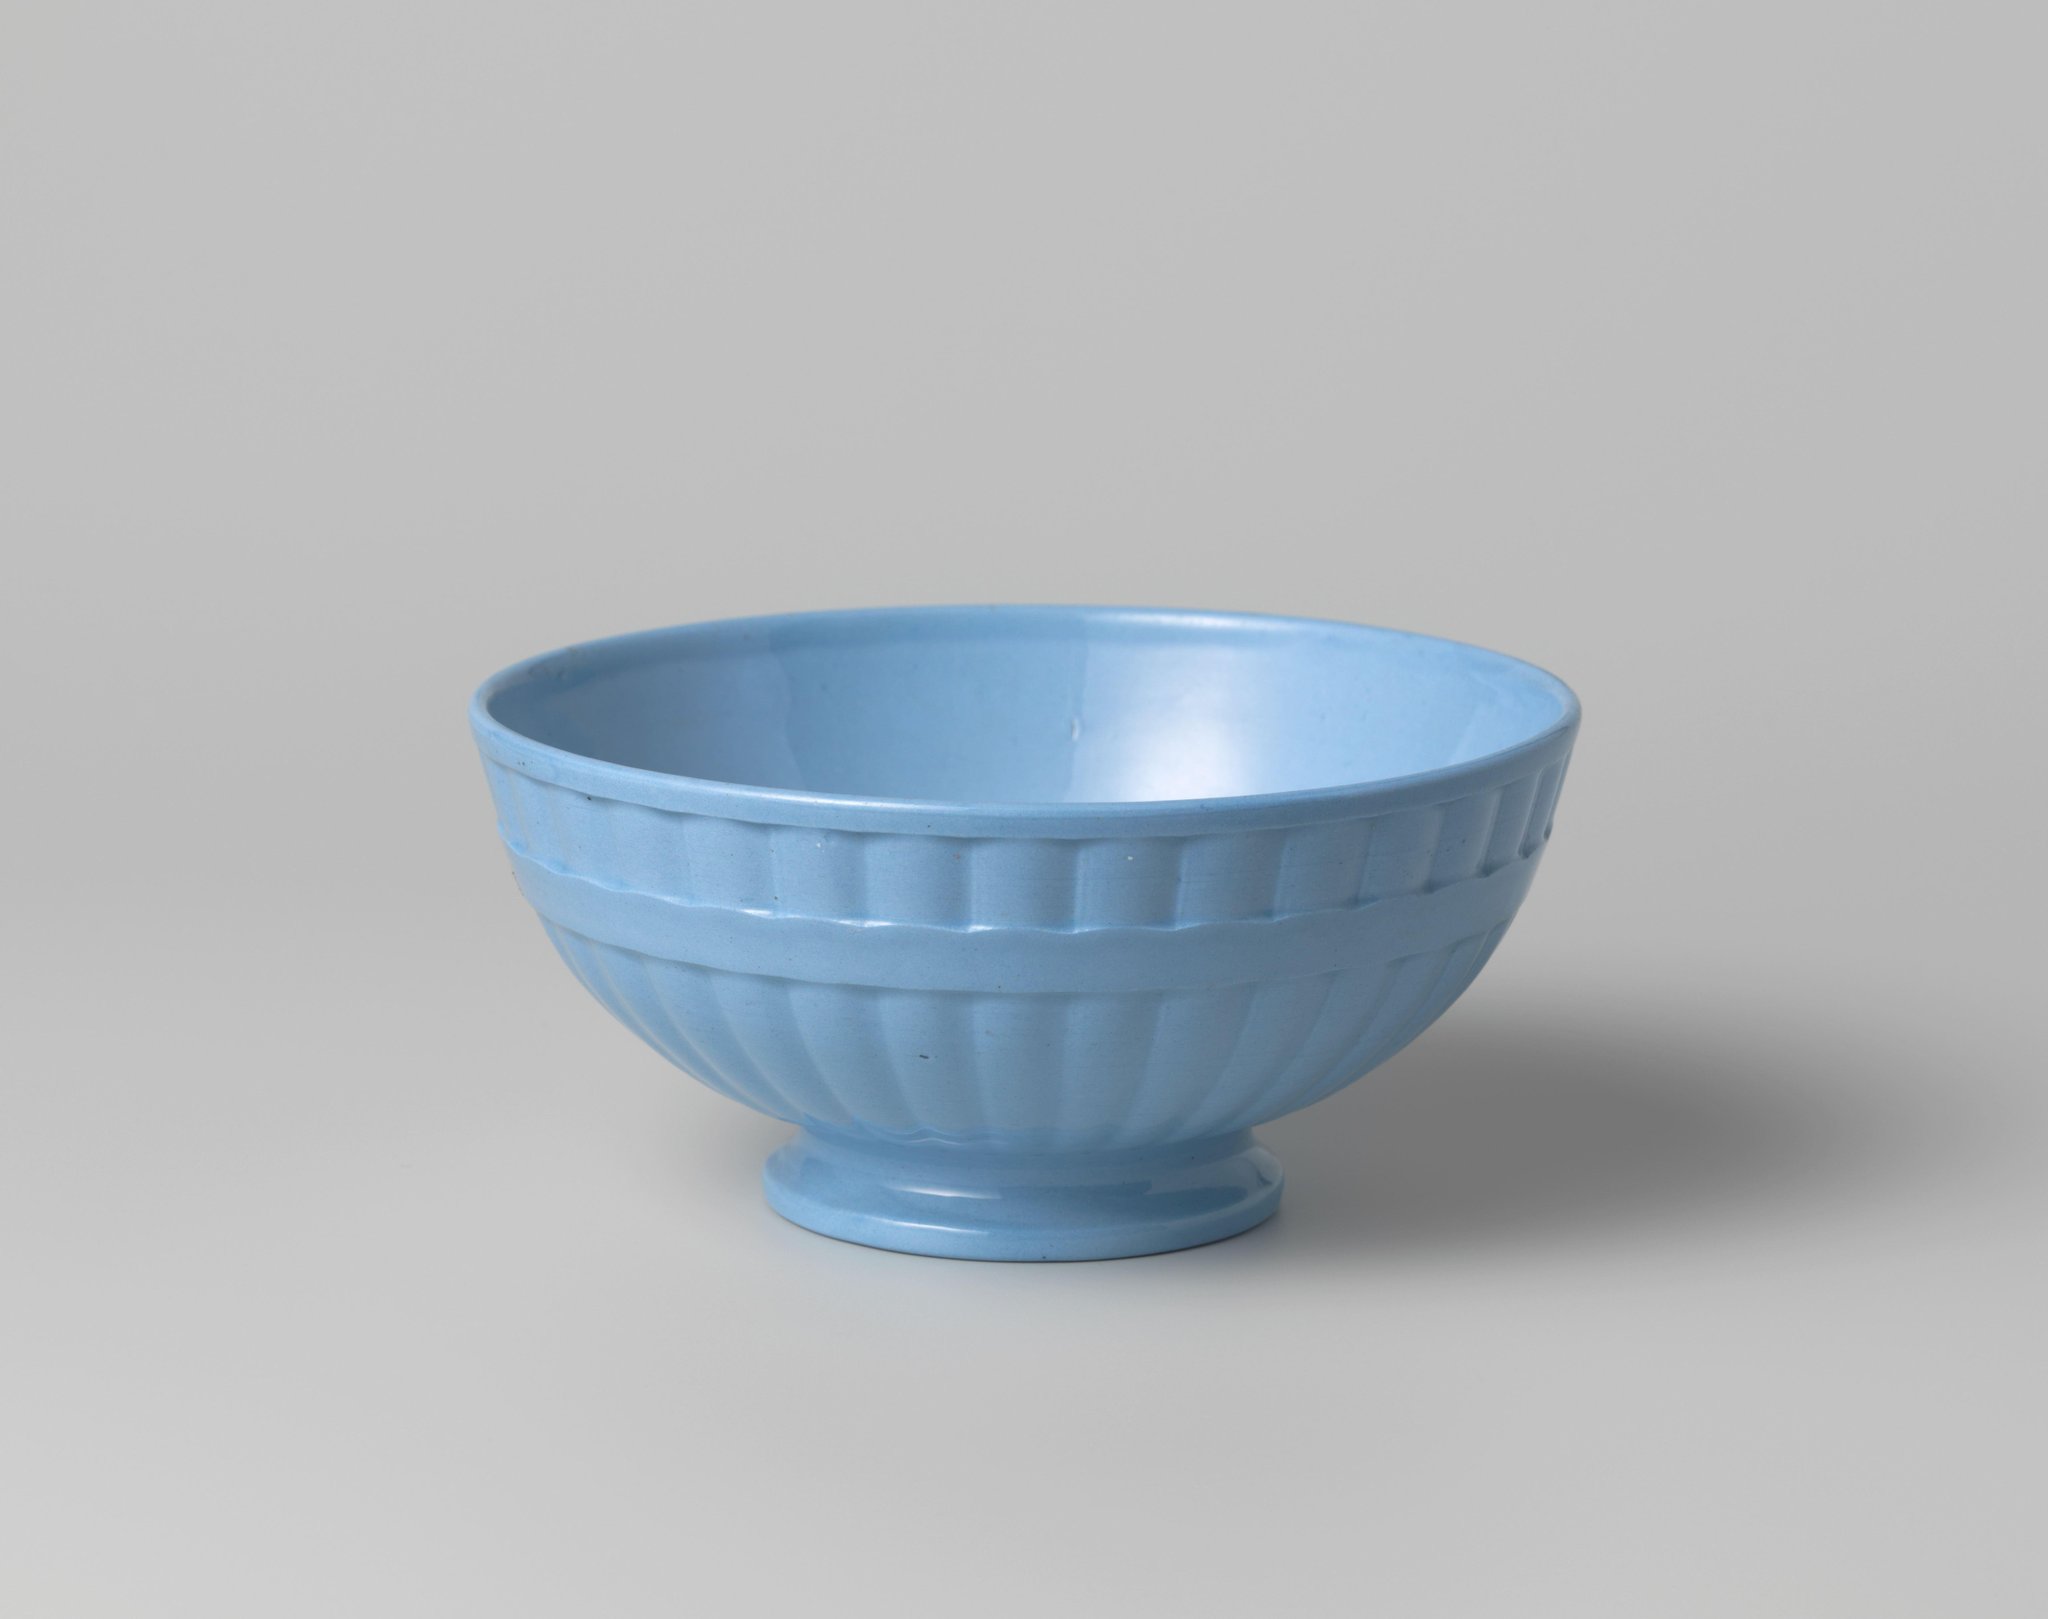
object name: bowl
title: Kom, blauw, met geschulpte wand, onderbroken door een gladde horizontale band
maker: petrus regout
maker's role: plateelbakker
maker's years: 1801-1879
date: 1860-1890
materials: stoneware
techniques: engels steengoed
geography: maastricht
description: Kom van aardewerk, blauwsteen. De geschulpte wand wordt onderbroken door een gladde horizontale band.